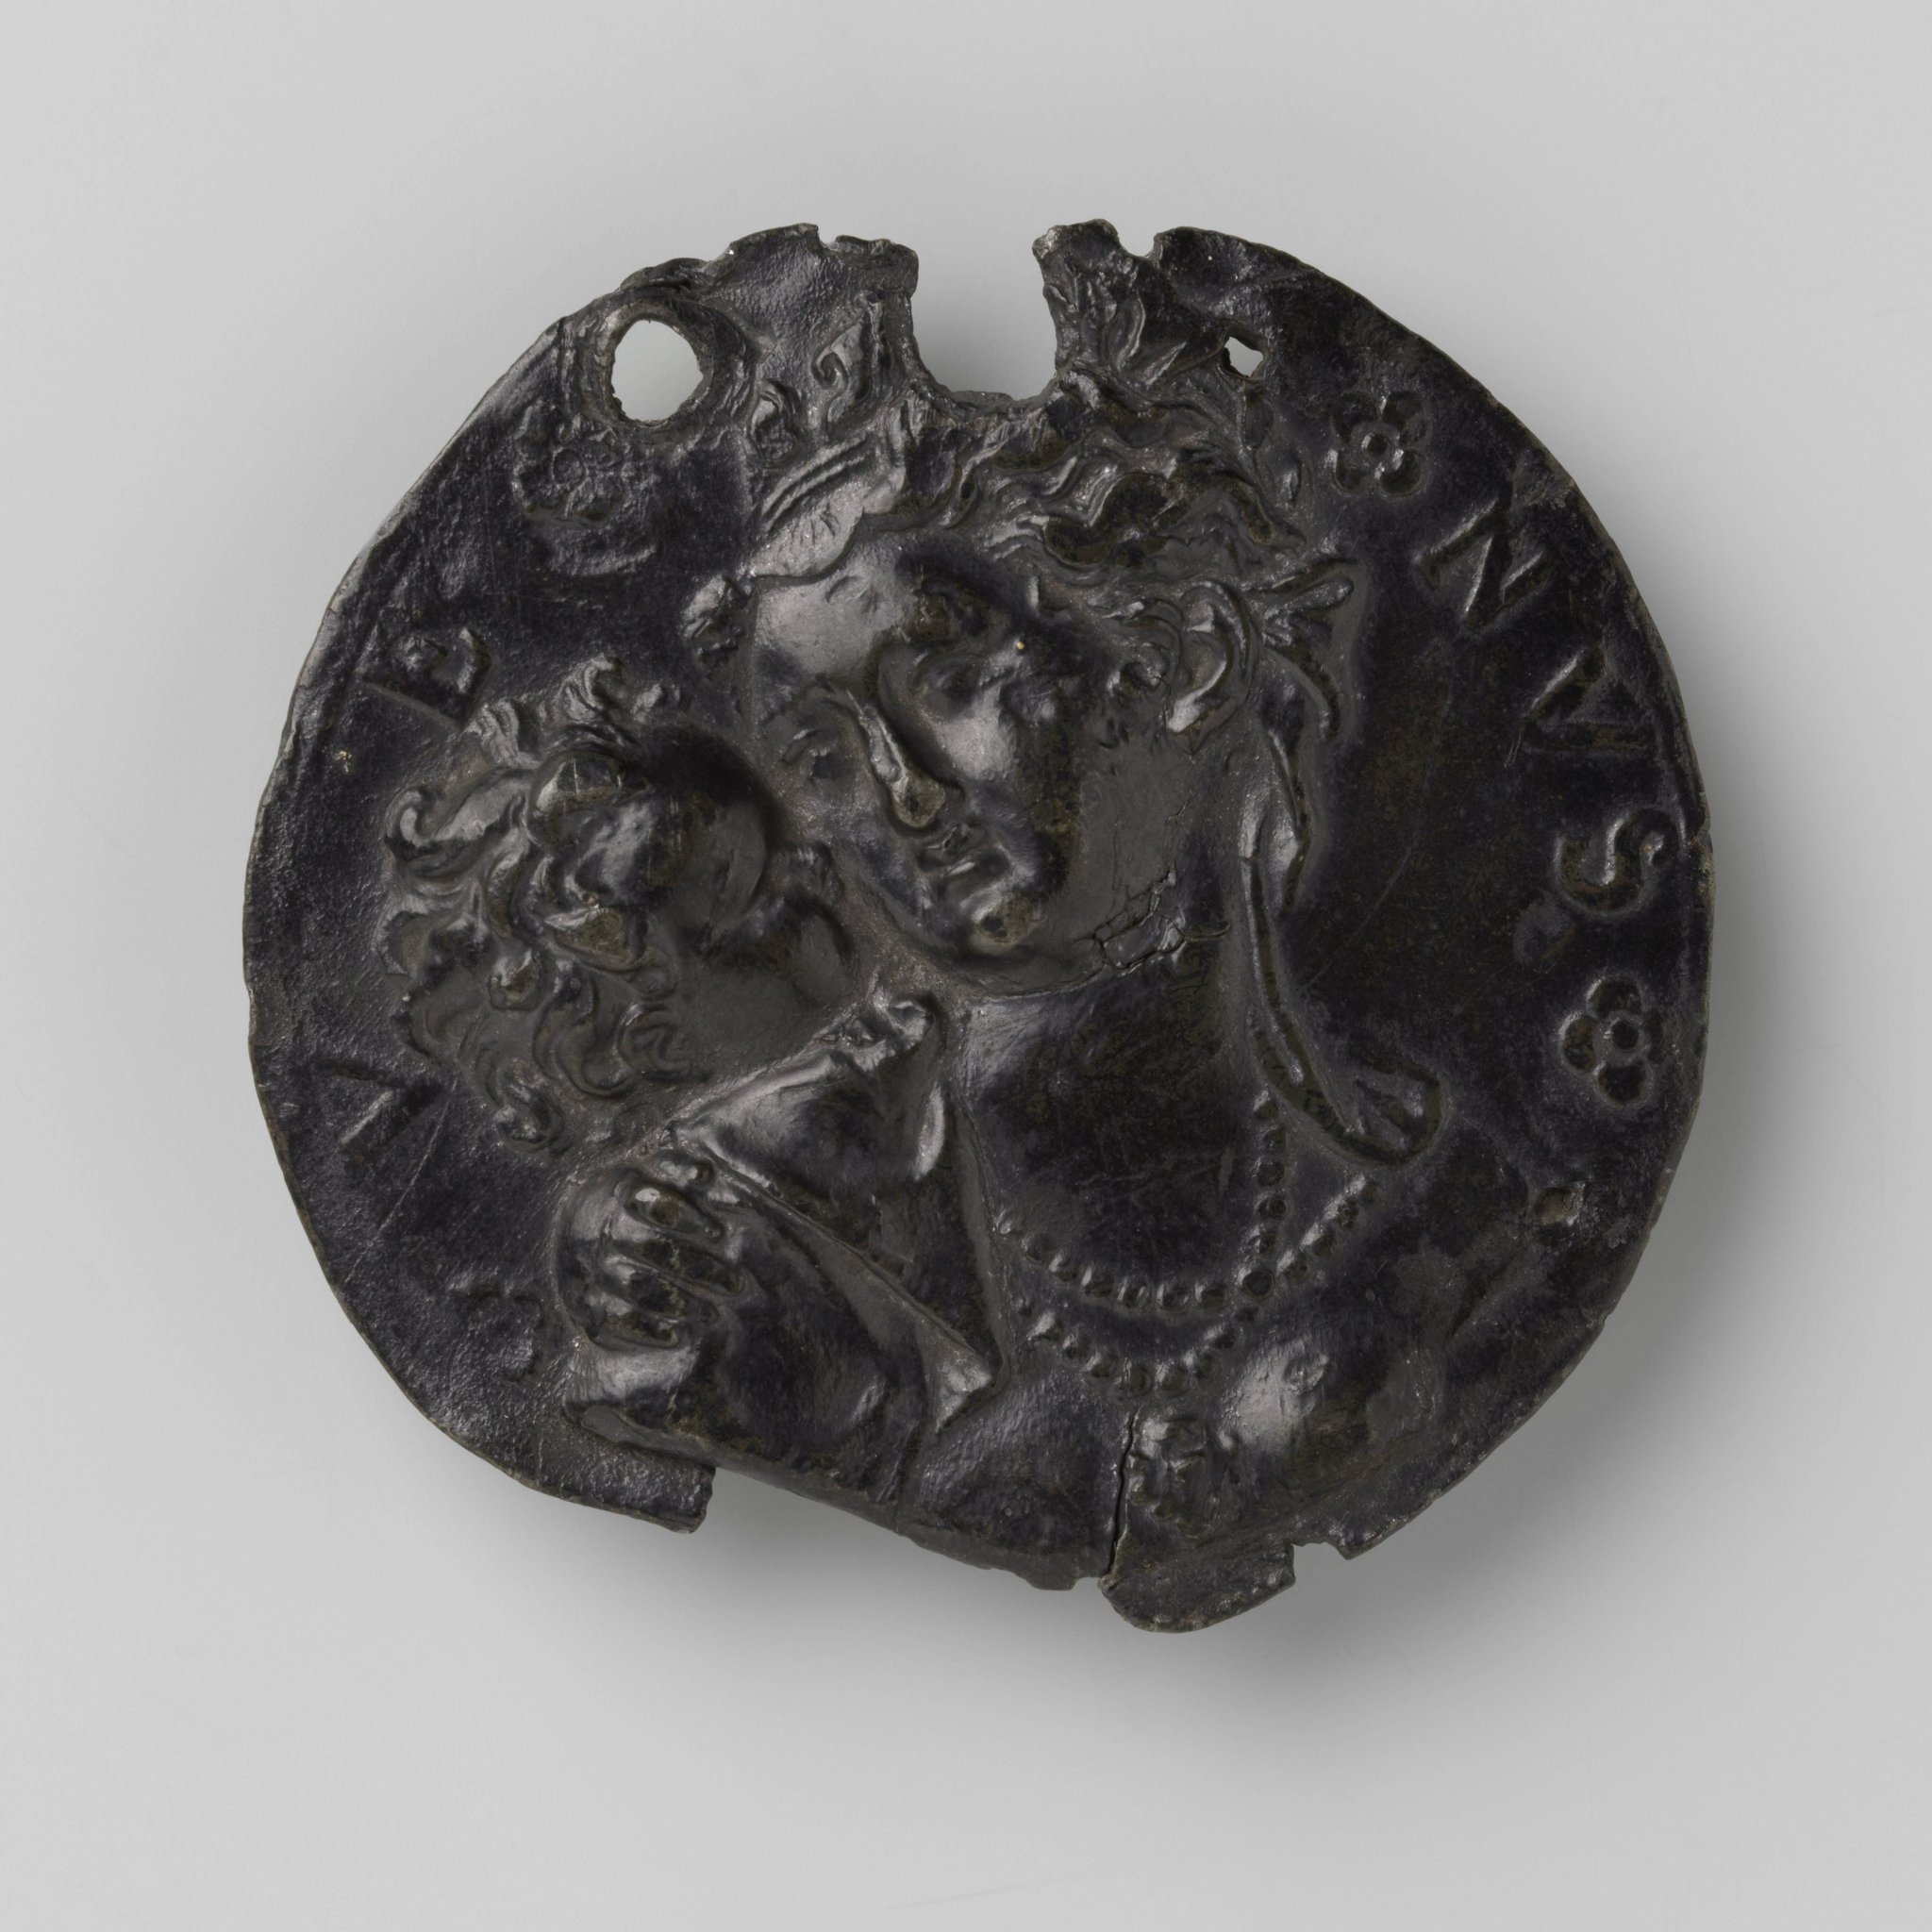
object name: plaque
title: Plaquette met Venus en Cupido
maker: Anonymous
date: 1600-1699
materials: lead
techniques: casting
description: Een ronde plaquette van lood met een voorstelling van een Venuskop met Cupido en een randschrift: Venus. De plaquette is boven en beneden geschonden.